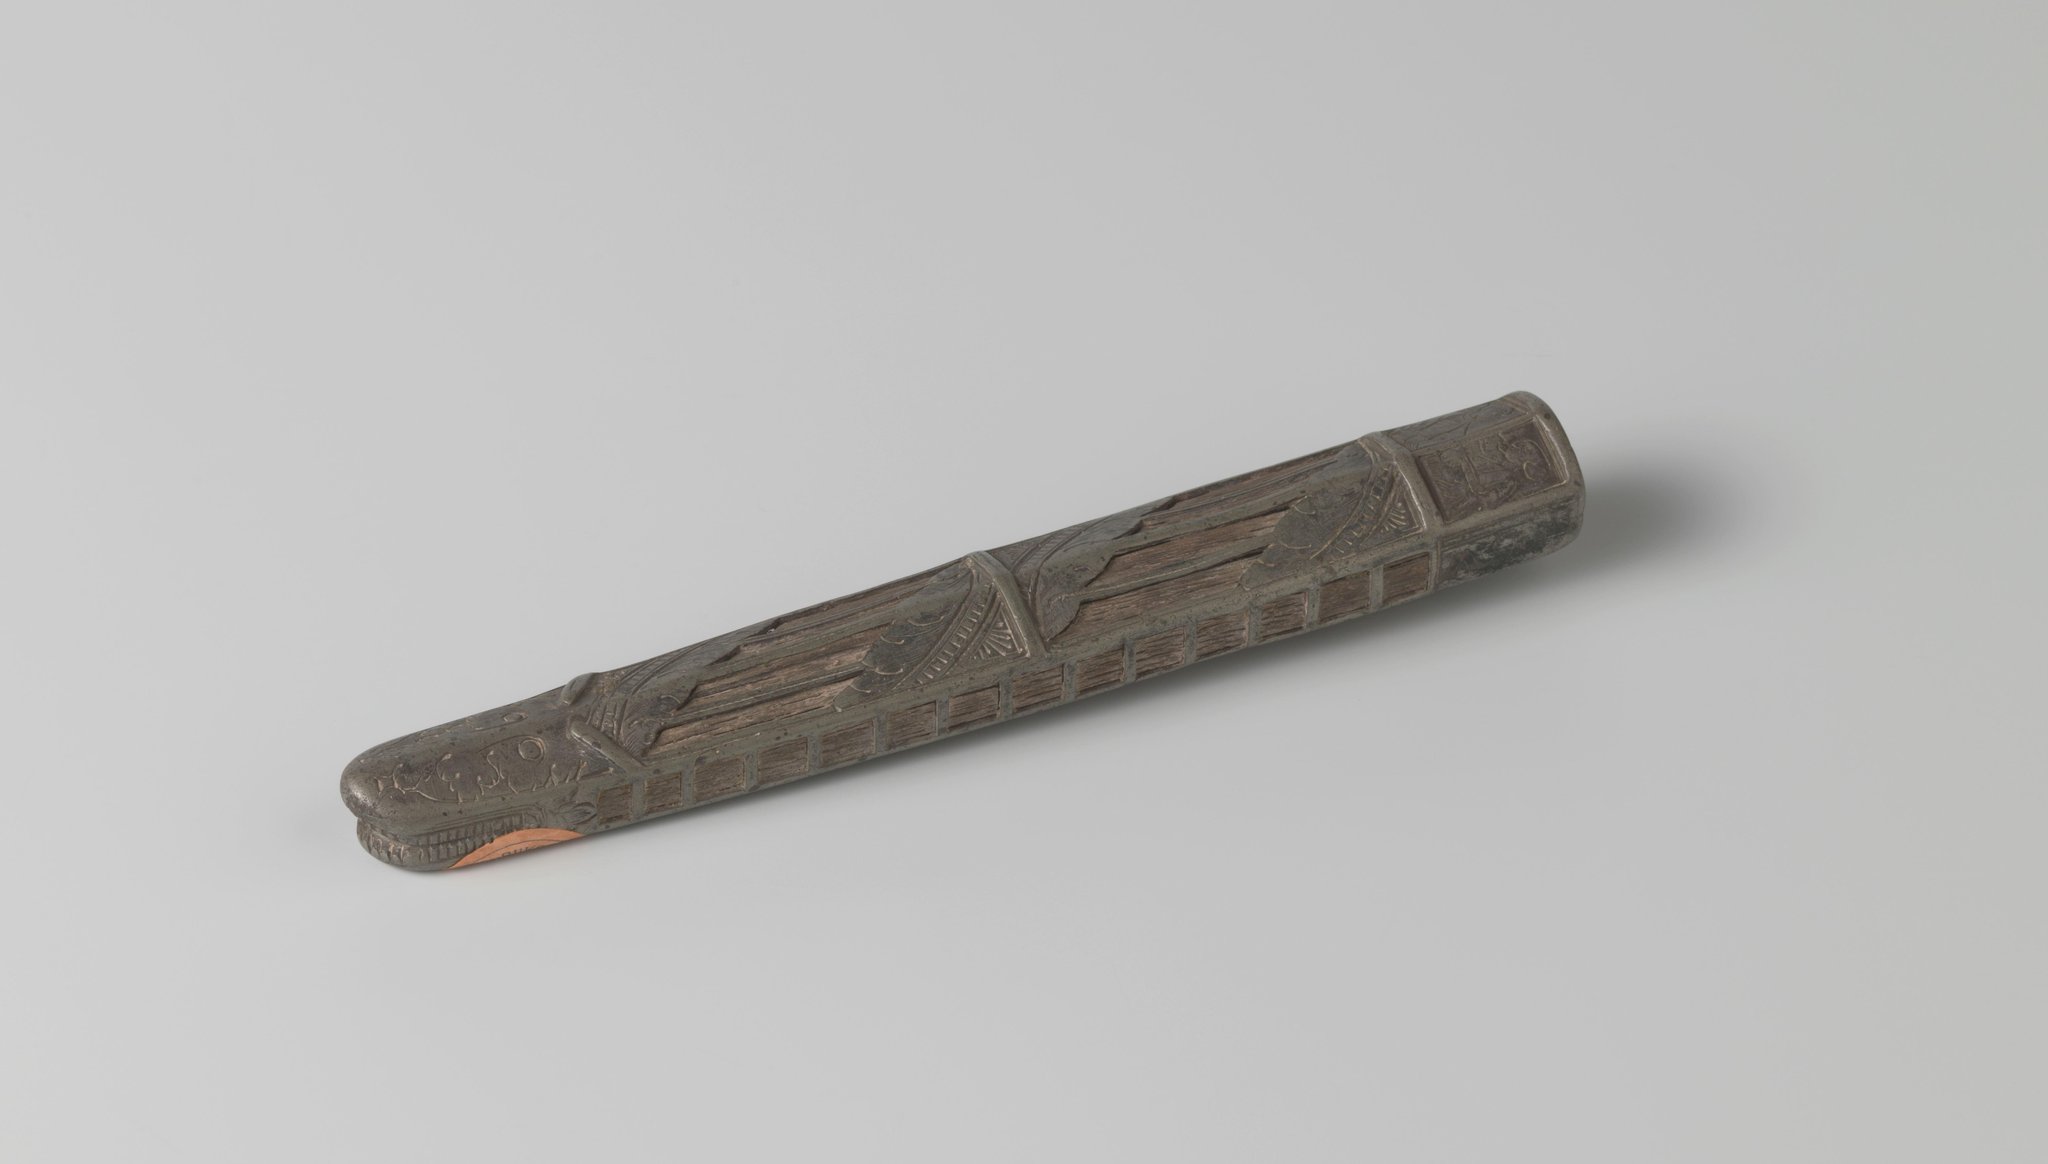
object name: case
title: Foedraal voor een mes van hout en beslag van tin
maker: Anonymous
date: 1578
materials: tin, wood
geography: germany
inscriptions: inscription: ‘1578’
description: Houten foedraal voor een mes, waarbij het lemmet in de schede kan worden gestoken. Het tinnen beslag is versierd met ornamenten en heeft openingen, waardoor het hout zichtbaar is. Bij de opening van het foedraal zijn halffiguren van een man en een vrouw te zien, de achterzijde heeft een aanzet om een koord doorheen te halen. De onderzijde van het foedraal is versierd met drakenkop.